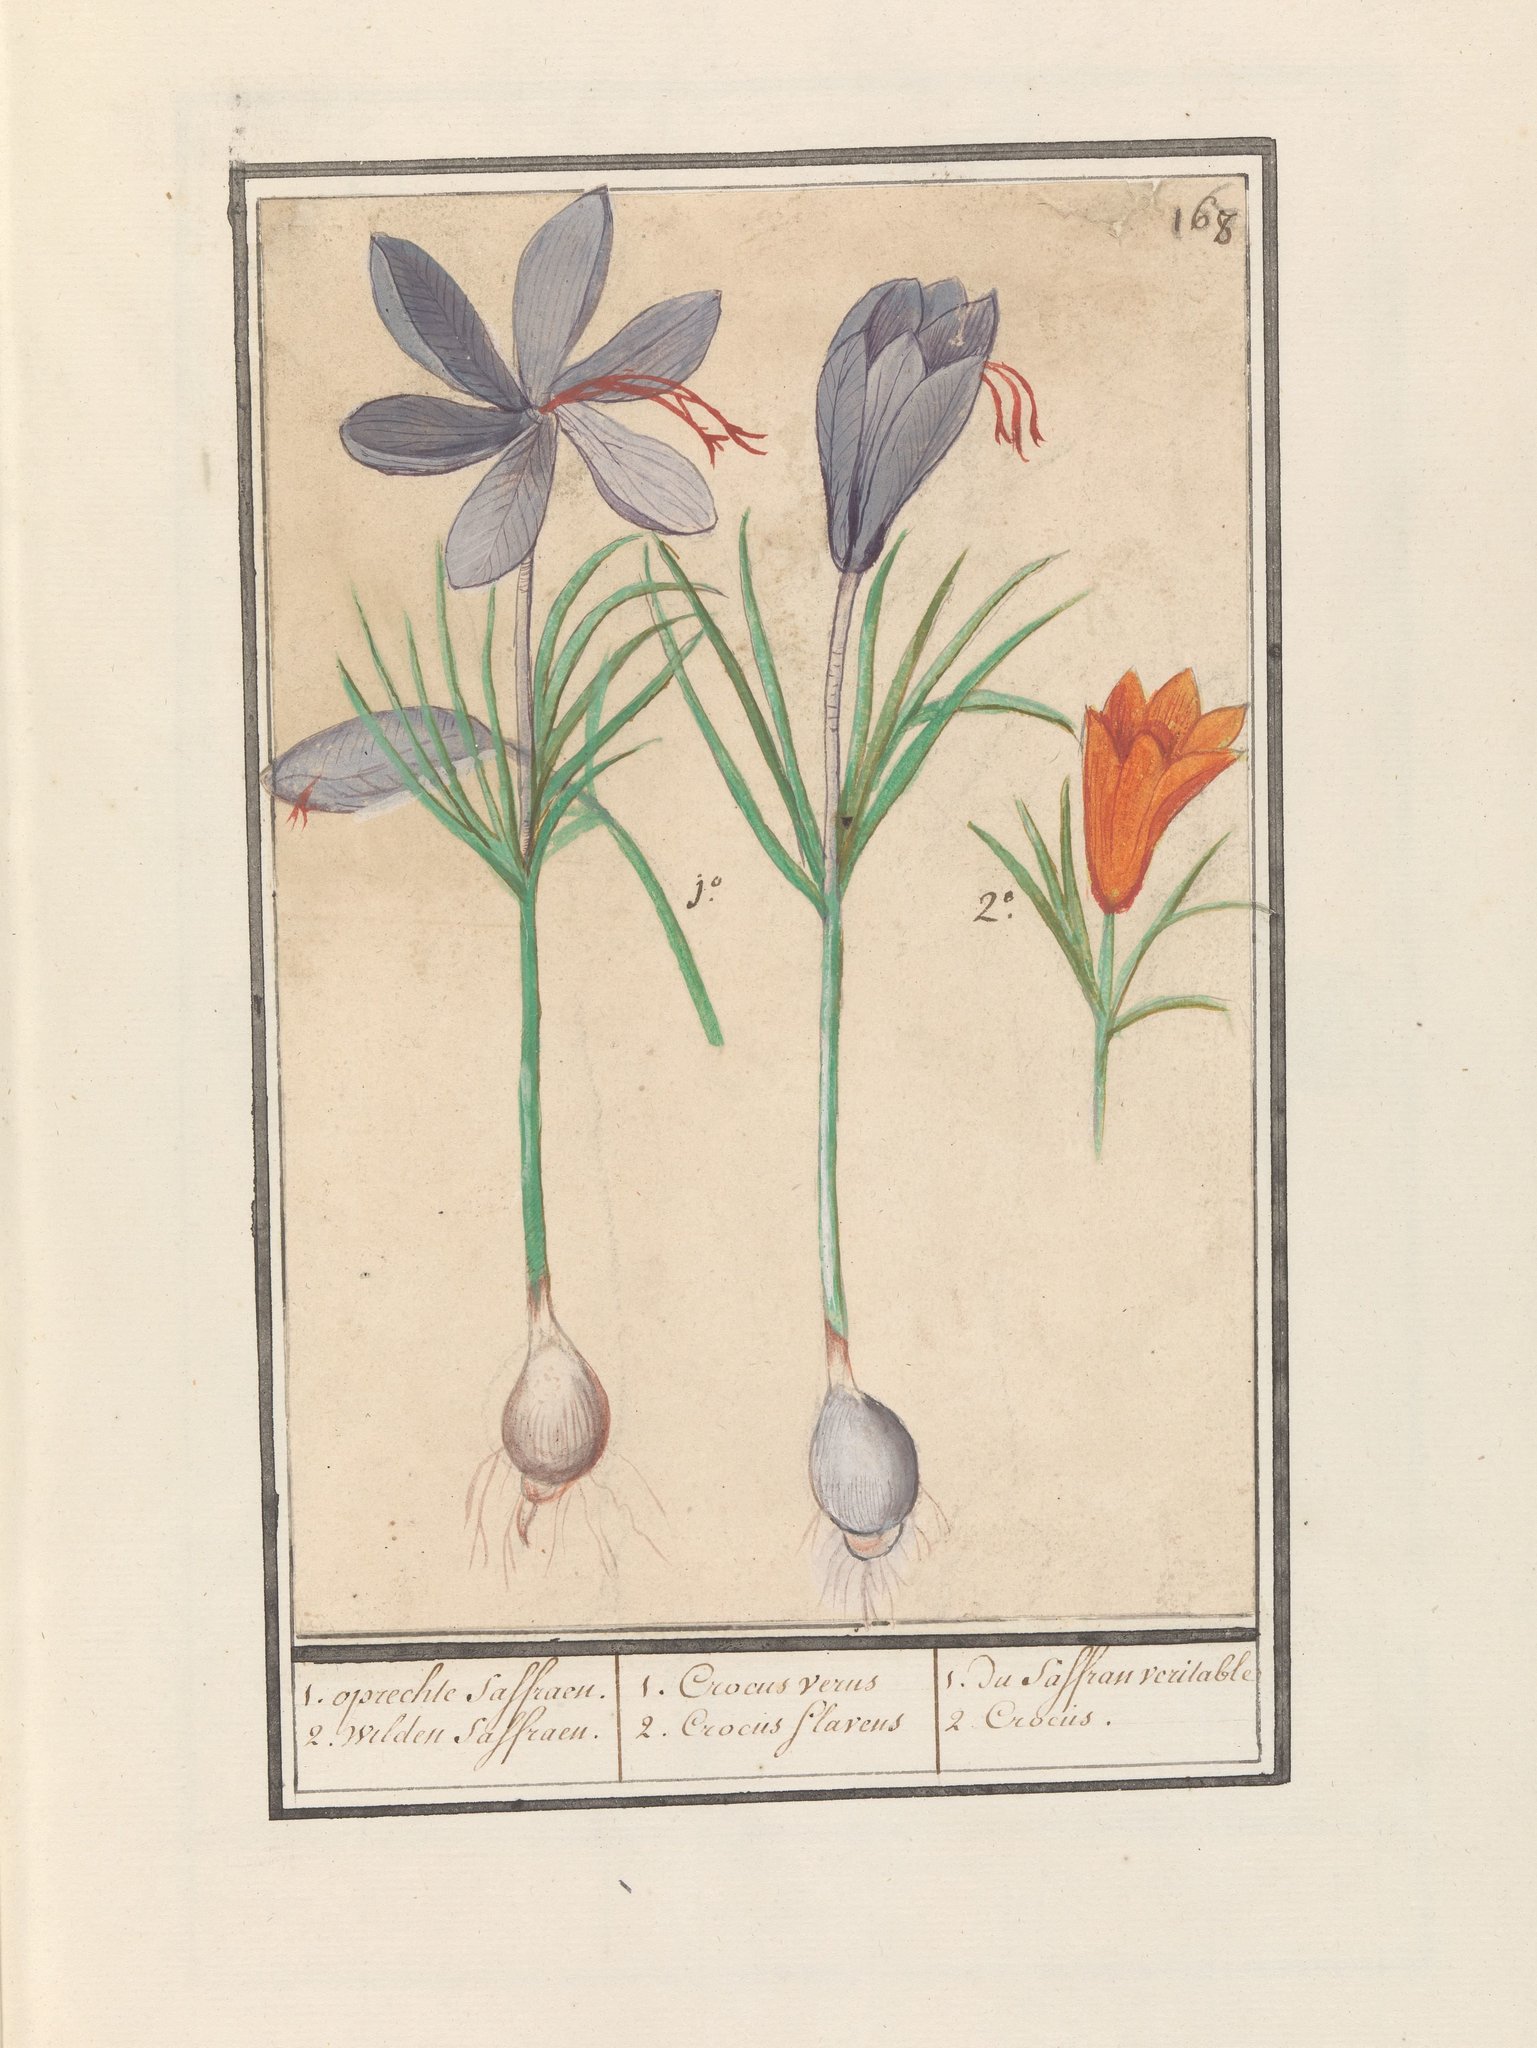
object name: drawing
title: Saffraankrokus (Crocus sativus)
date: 1596-1610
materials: chalk, paint, paper, watercolor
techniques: brush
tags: flowers: saffron crocus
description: Blauwe saffraankrokus en oranje wilde krokus. Rechtsboven genummerd: 168. Onderdeel van het tweede album met tekeningen van bloemen en planten. Negende van twaalf albums met tekeningen van dieren, vogels en planten bekend rond 1600, gemaakt in opdracht van keizer Rudolf II. Met toelichting in Nederlands, Latijn en Frans.